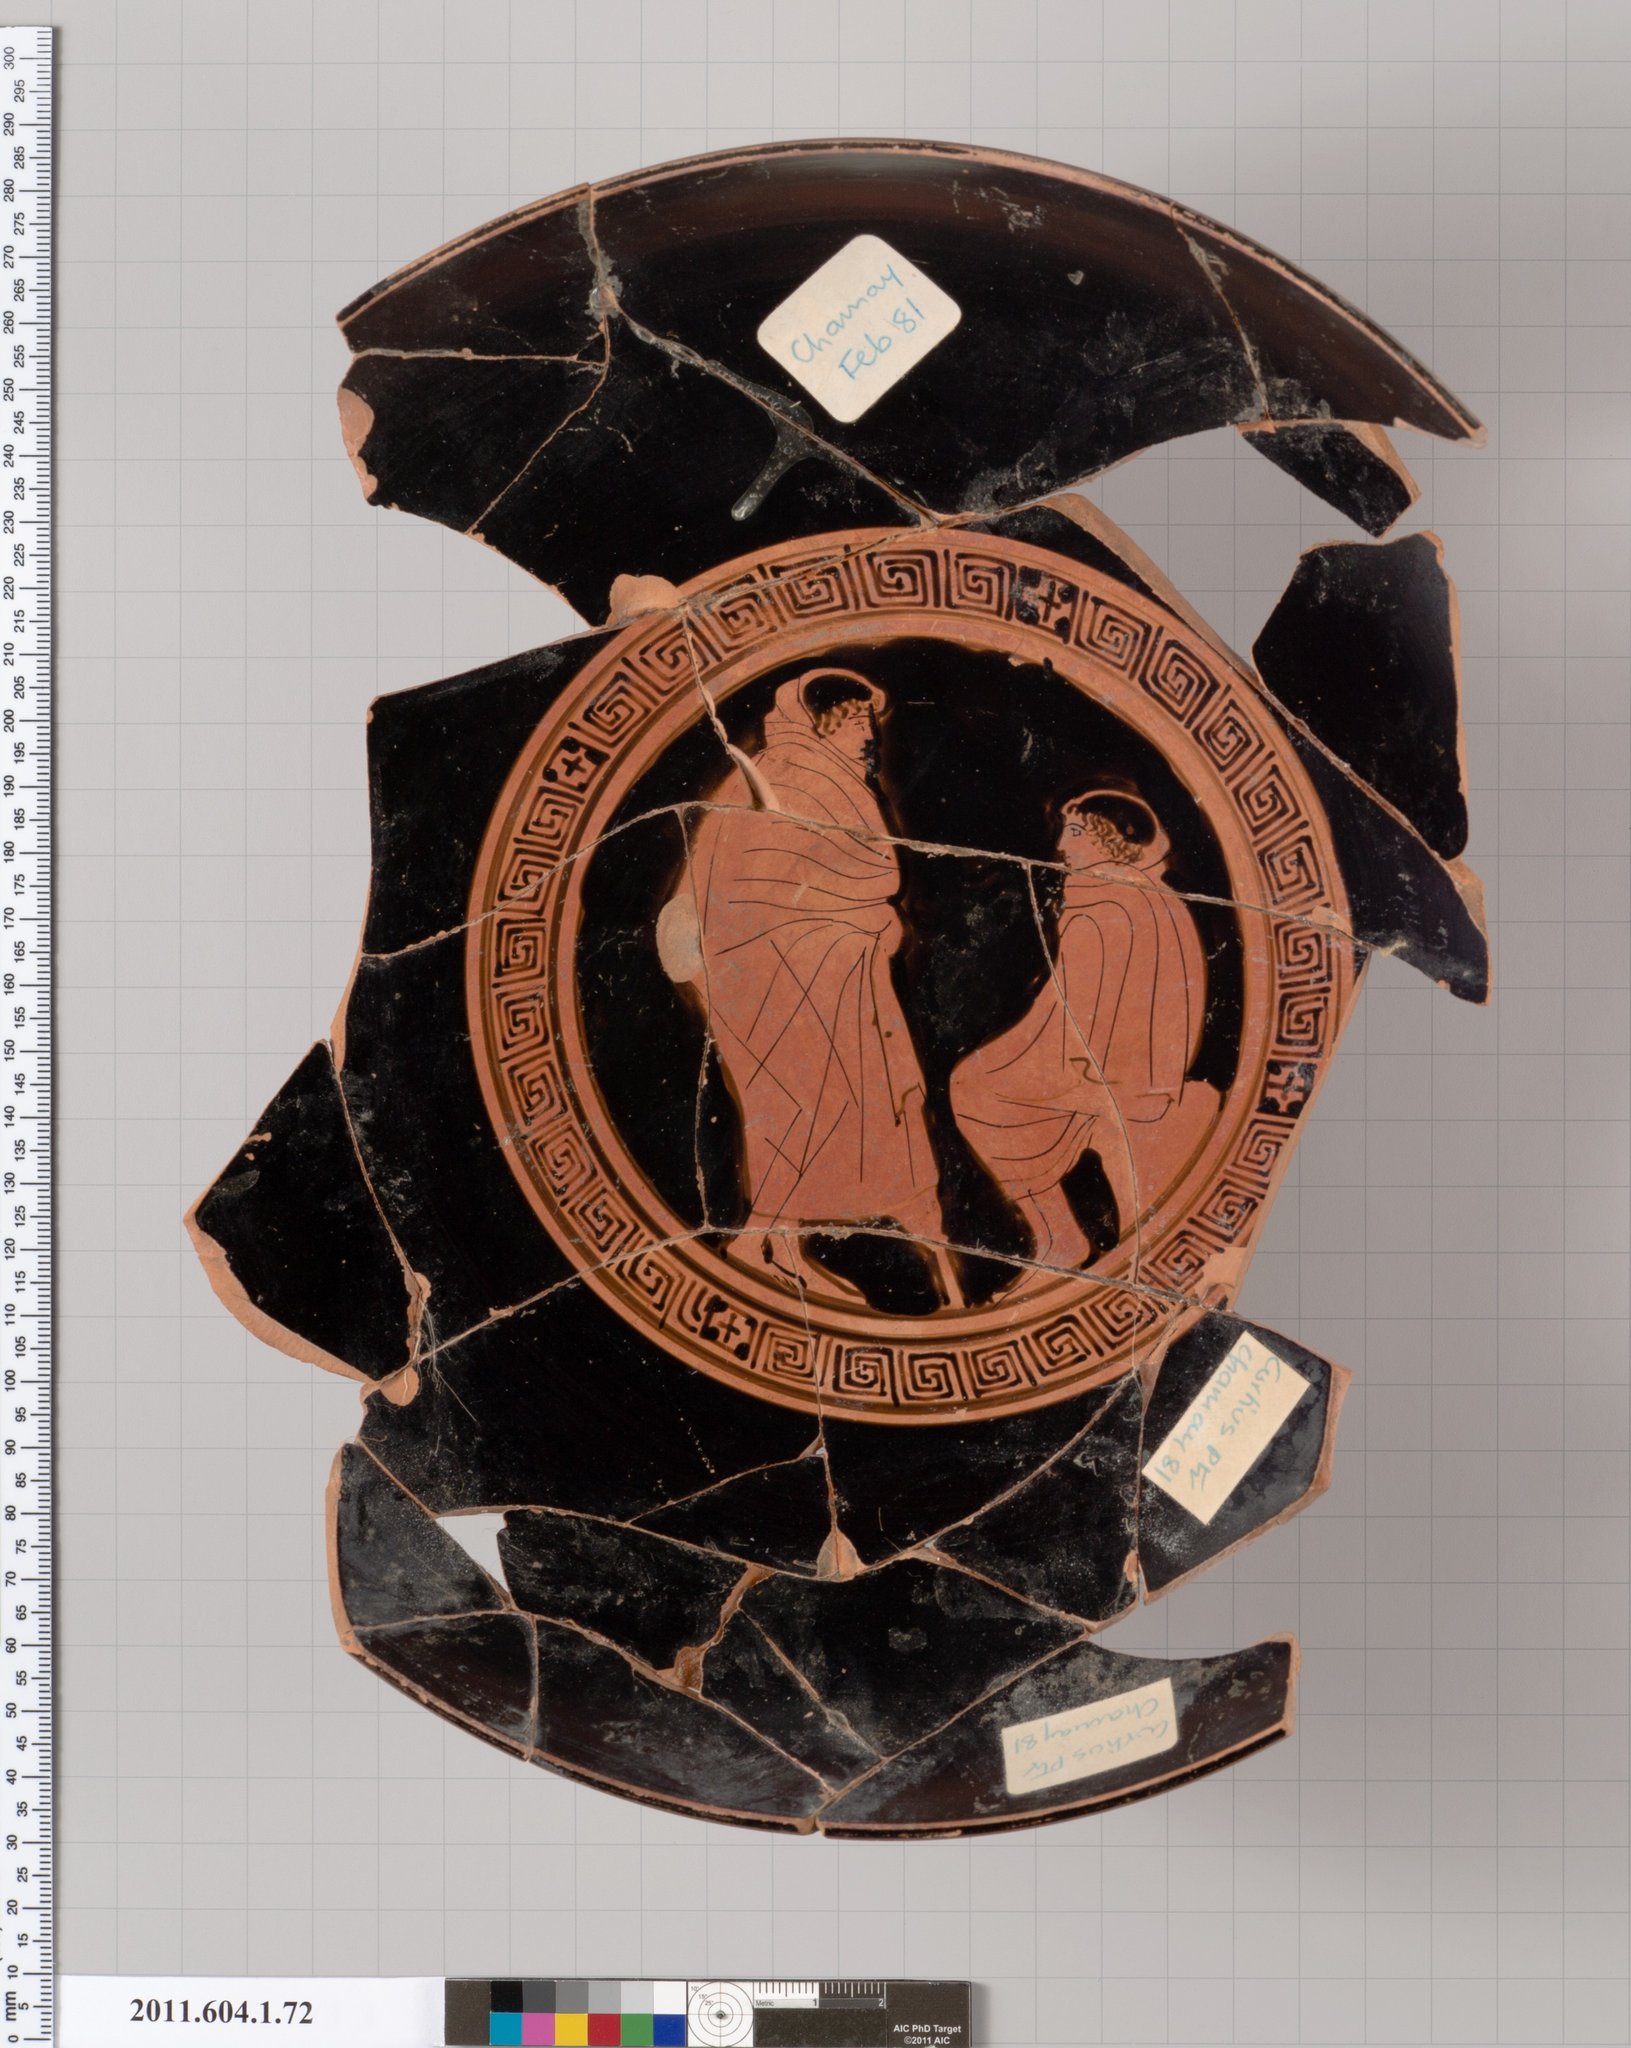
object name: kylix fragment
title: Terracotta fragments of a kylix (drinking cup)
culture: greek, attic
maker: curtius painter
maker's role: artist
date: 475-451 BCE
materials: terracotta